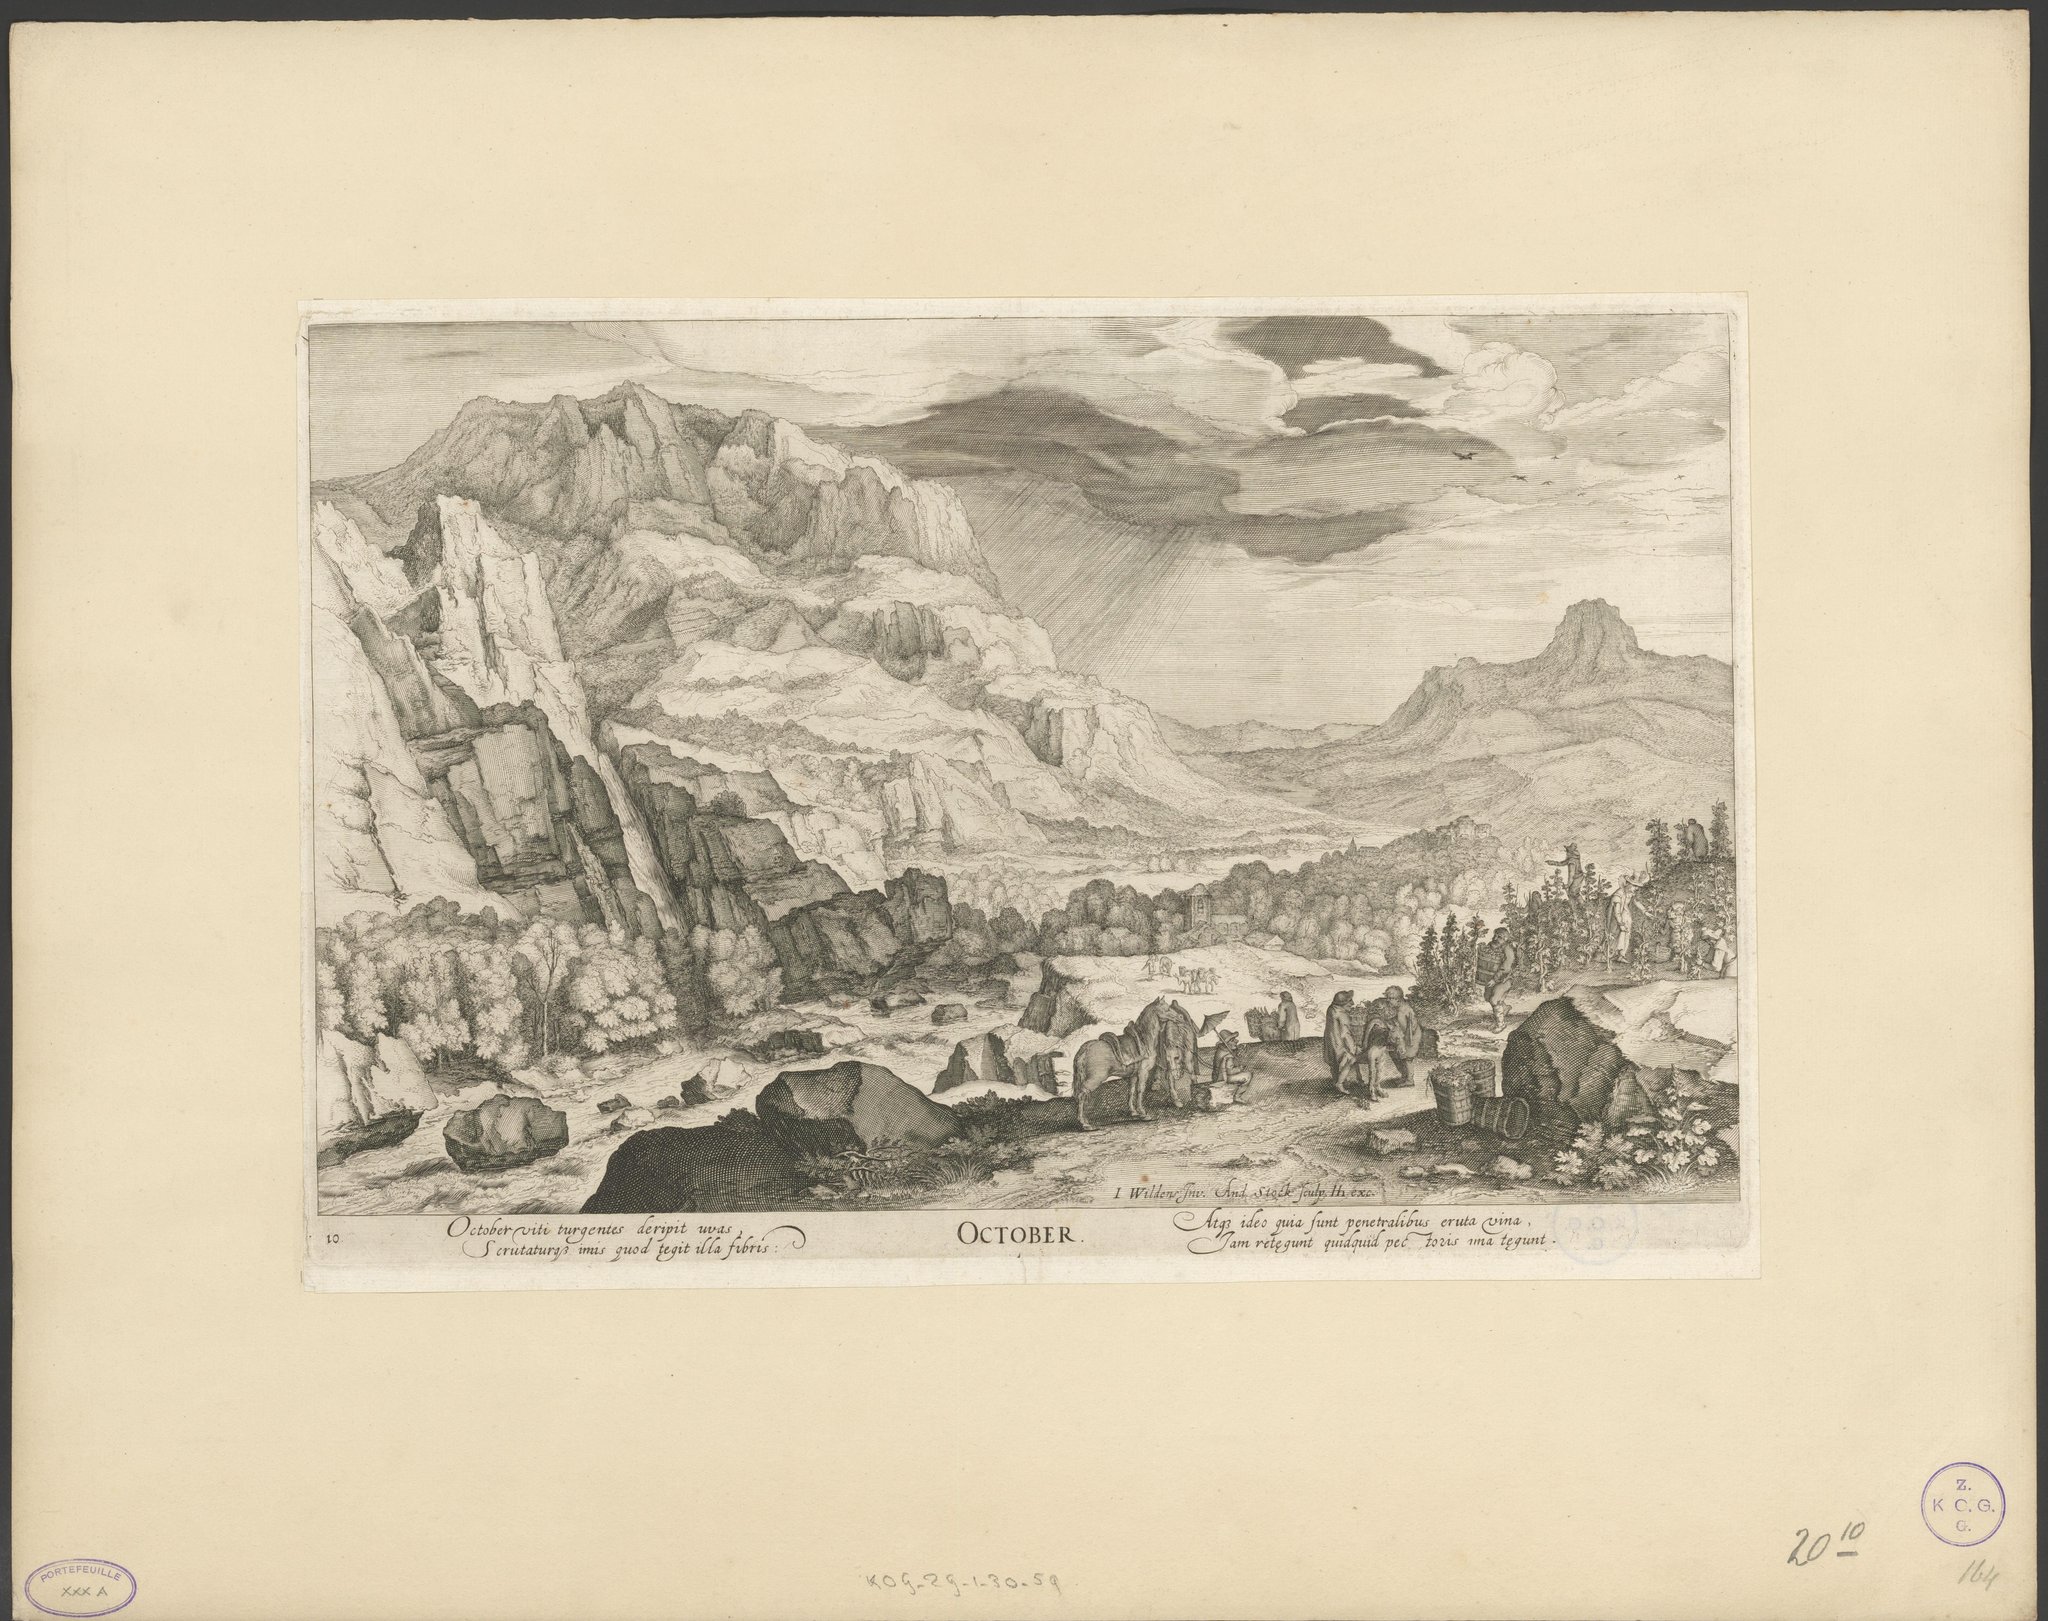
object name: print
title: Oktober, landschap met de wijnoogst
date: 1614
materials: paper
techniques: engraving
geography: the hague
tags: landscape symbolizing october (+ with scenes showing human occupations ~ seasons and months), october and its 'labours'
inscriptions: collector's mark: Lugt 1641, collector's mark: Lugt 1641, stamp: 963, stamp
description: Landschap met rechts figuren, die druiven oogsten. De manden met druiven worden op ezels geladen. Links een beek. Verbeelding van de maand Oktober. Prent uit een serie van de twaalf maanden. Onderwerpsrubrieken binnen de Atlas Zeden en Gewoonten: Zeden en Gewoonten in engeren zin. Volksleven. Zinnebeeldige voorstellingen uit het volkleven op serieprenten. Maanden en diversen (allegorieën).